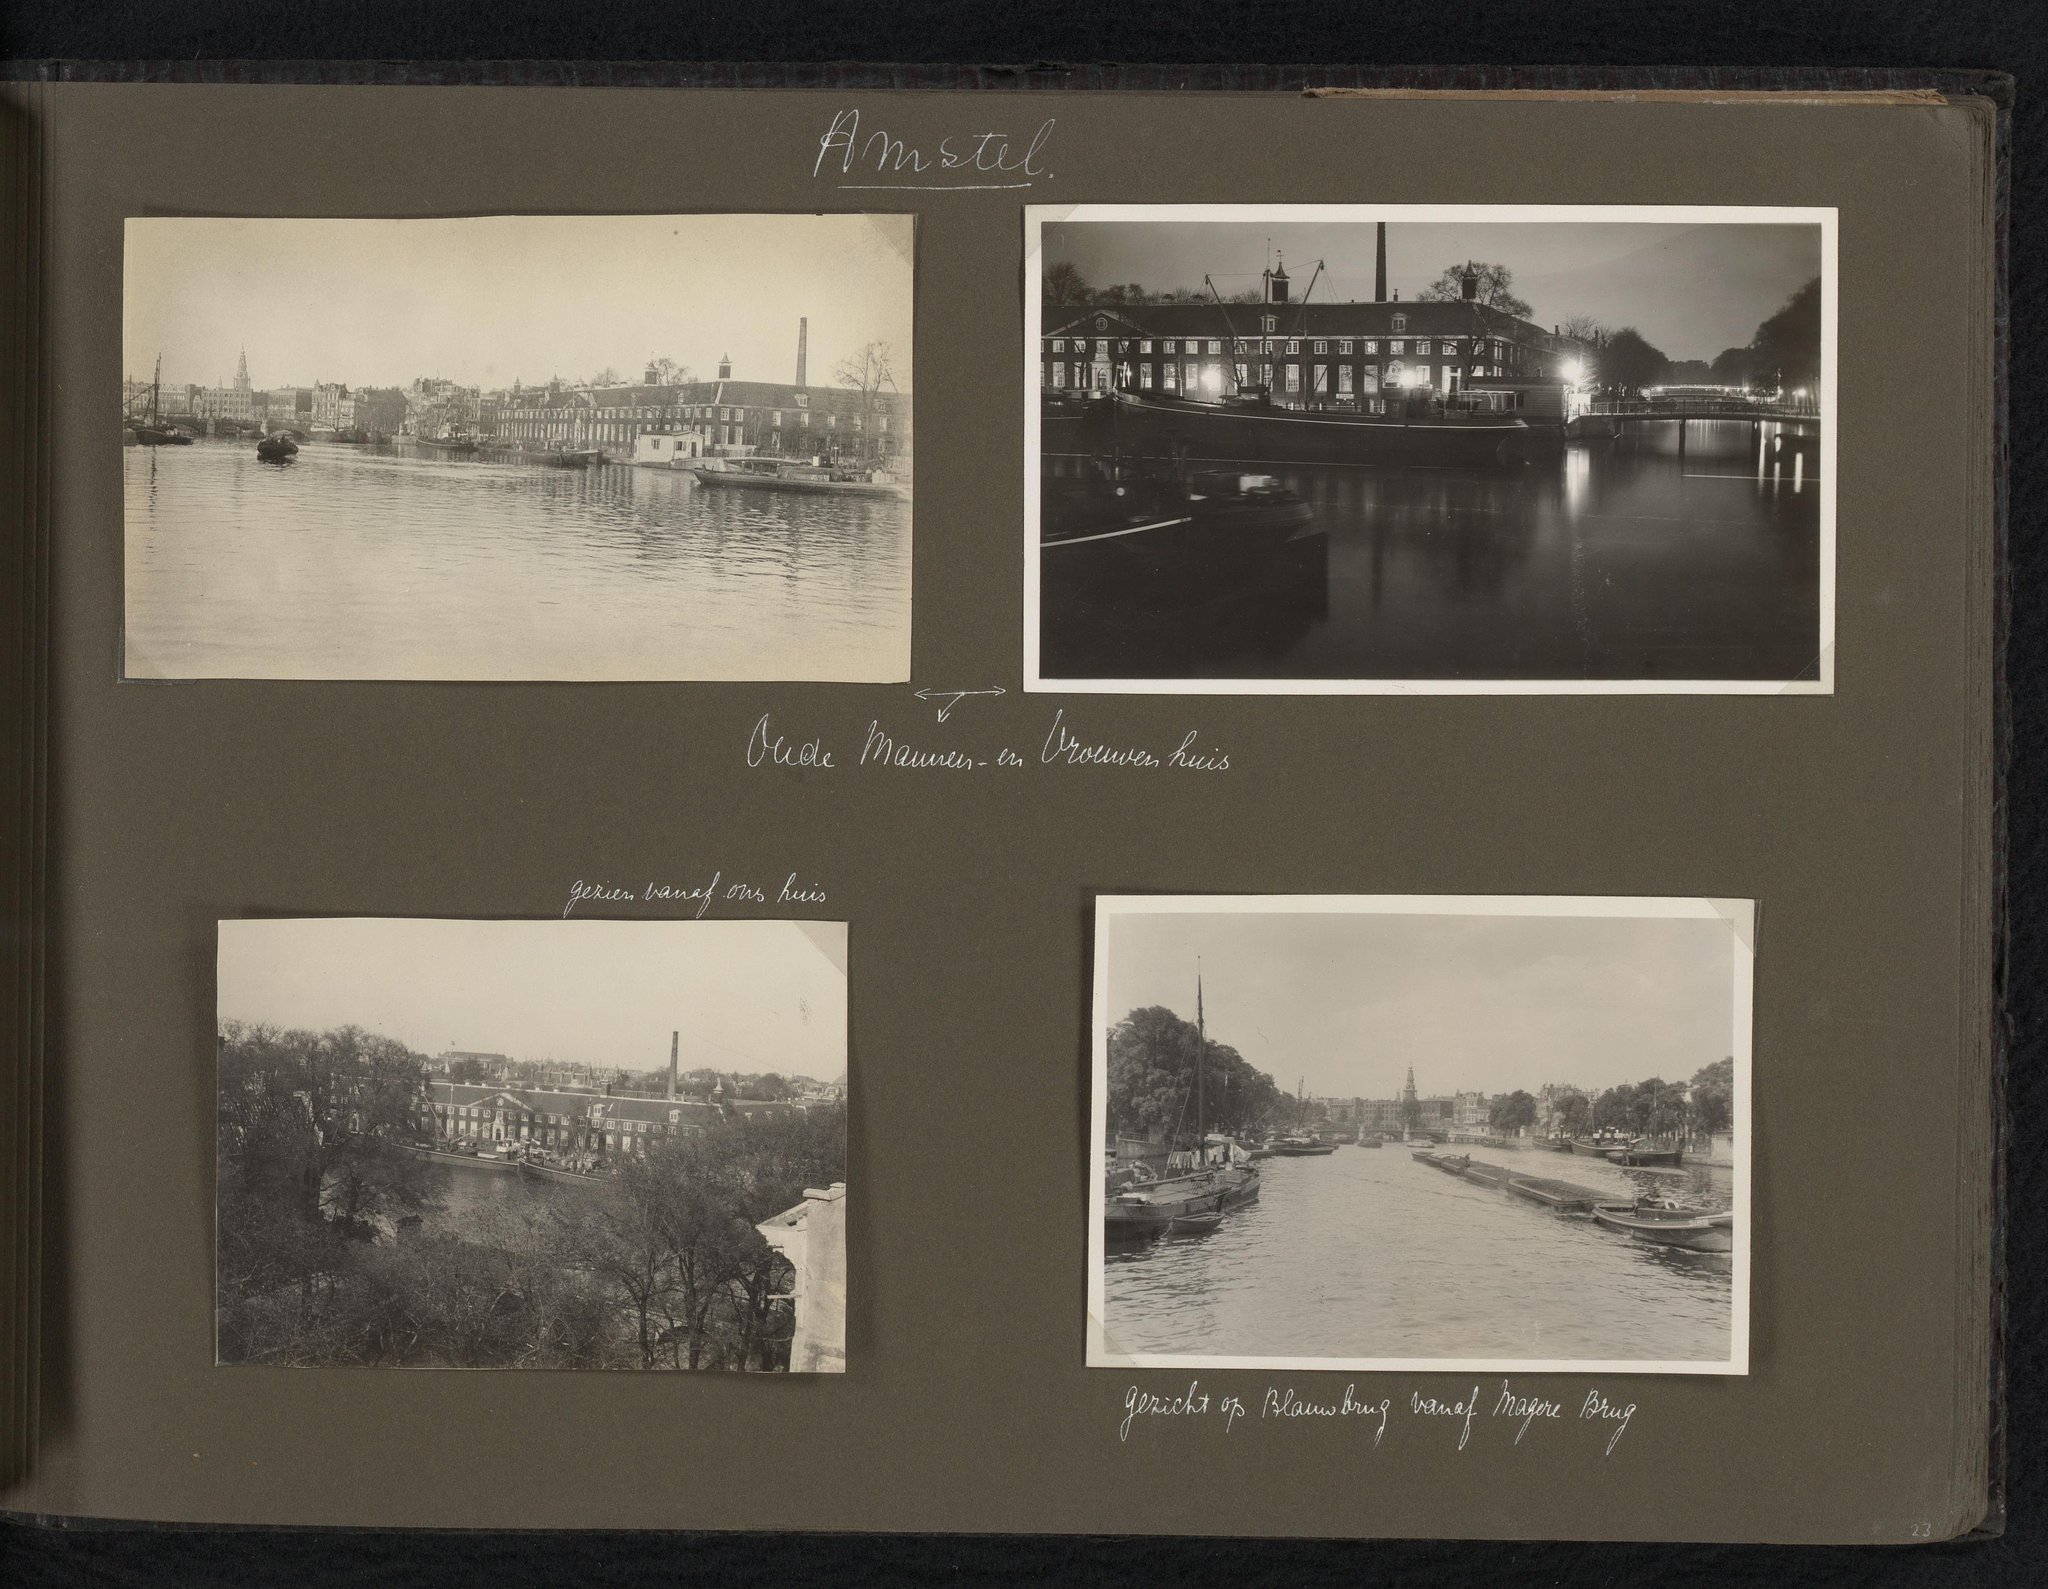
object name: photograph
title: Amstel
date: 1930-1931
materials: paper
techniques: gelatin silver print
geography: amsterdam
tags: canals, waters (in city), bridge in city across river, canal, etc.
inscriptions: inscription: ‘gezicht op Blauwbrug vanaf Magere Brug’, inscription: ‘gezien vanaf ons huis’, inscription: ‘Oude Mannen- en Vrouwenhuis’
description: Deze foto's maken deel uit van een album.